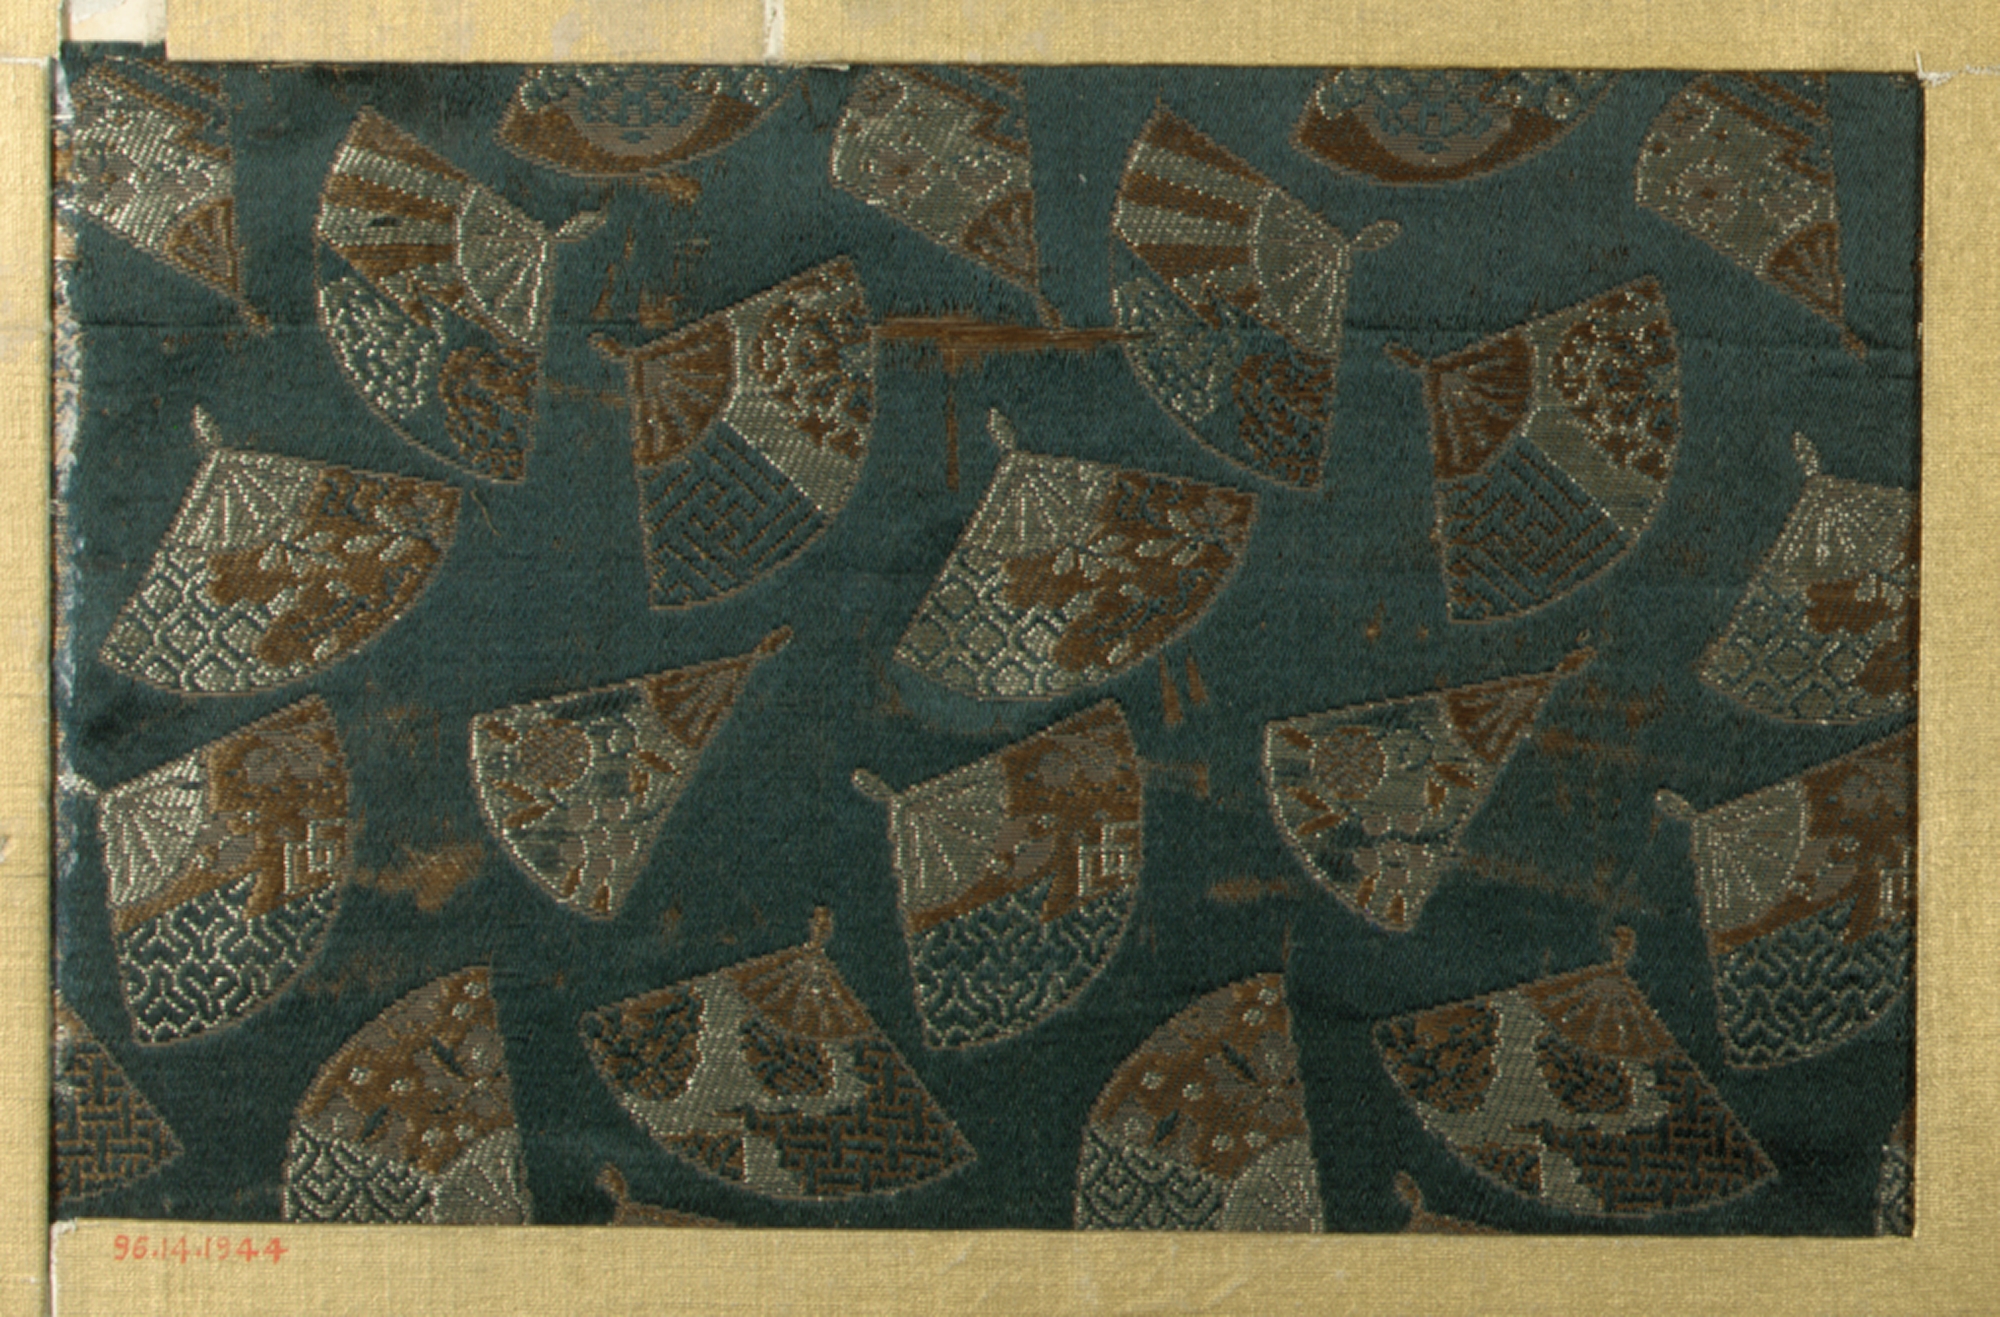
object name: piece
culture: japanese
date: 1701-1900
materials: silk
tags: fans